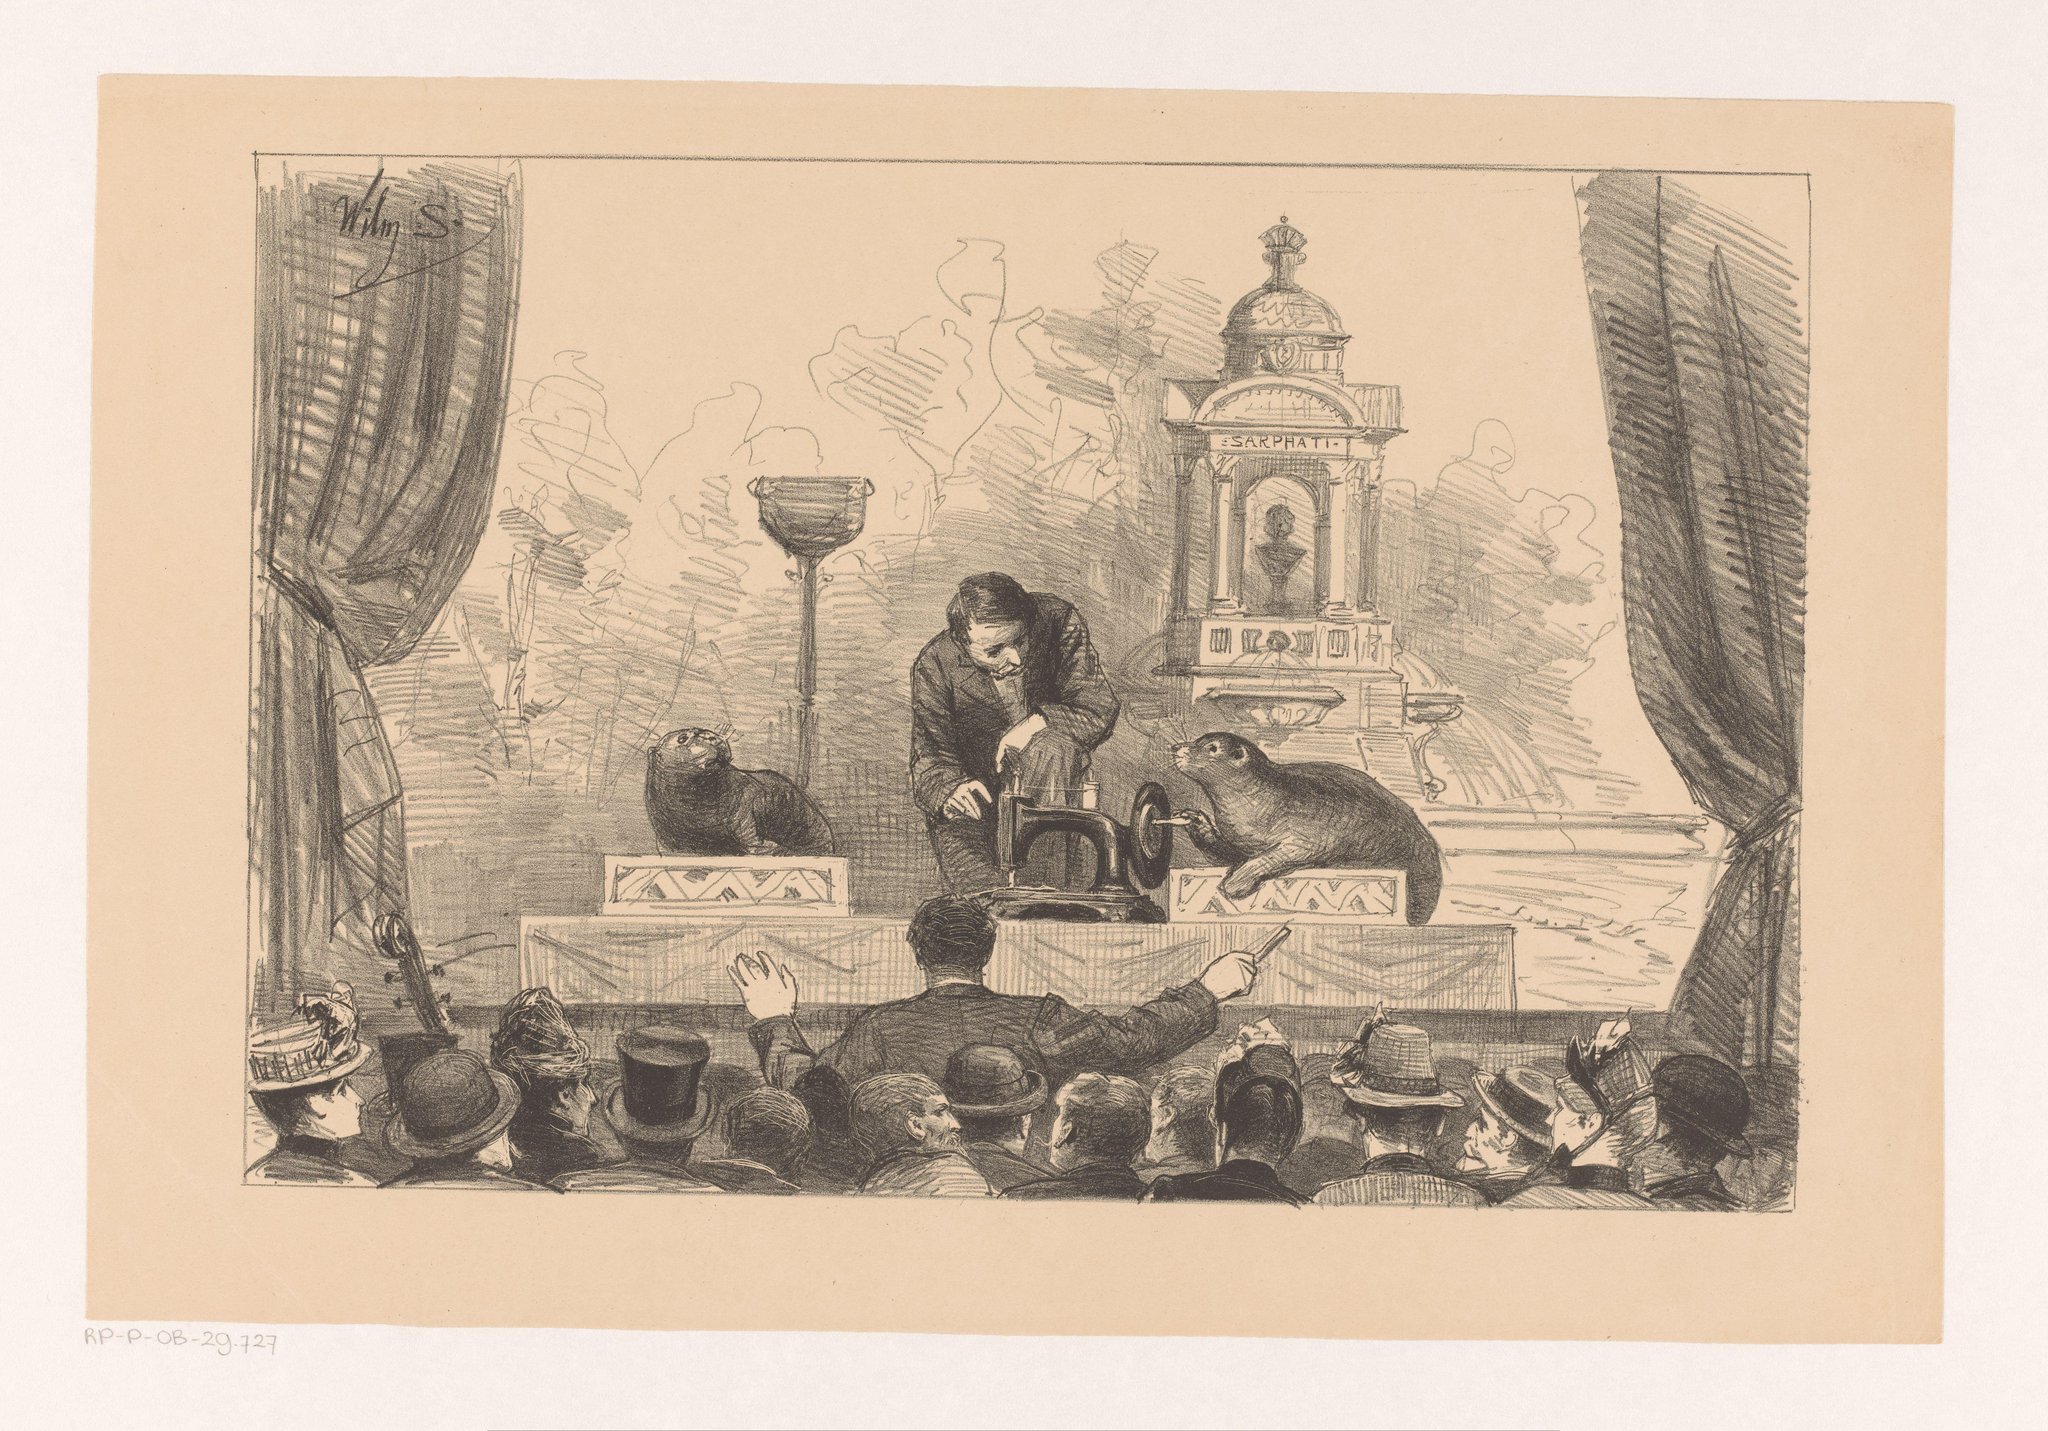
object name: print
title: Spotprent op het Paleis voor Volksvlijt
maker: willem steelink (ii)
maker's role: draughtsman, print maker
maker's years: 1856-1928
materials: paper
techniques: lithograph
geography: netherlands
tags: amsterdam, samuel sarphati, the show; fair and circus performers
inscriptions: collector's mark: Lugt 2228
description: Dokter Samuel Sarphati zit op een knie tussen twee zeehonden waarvan er één een naaimachine bediend. Op de voorgrond staan een dirigent en toeschouwers.